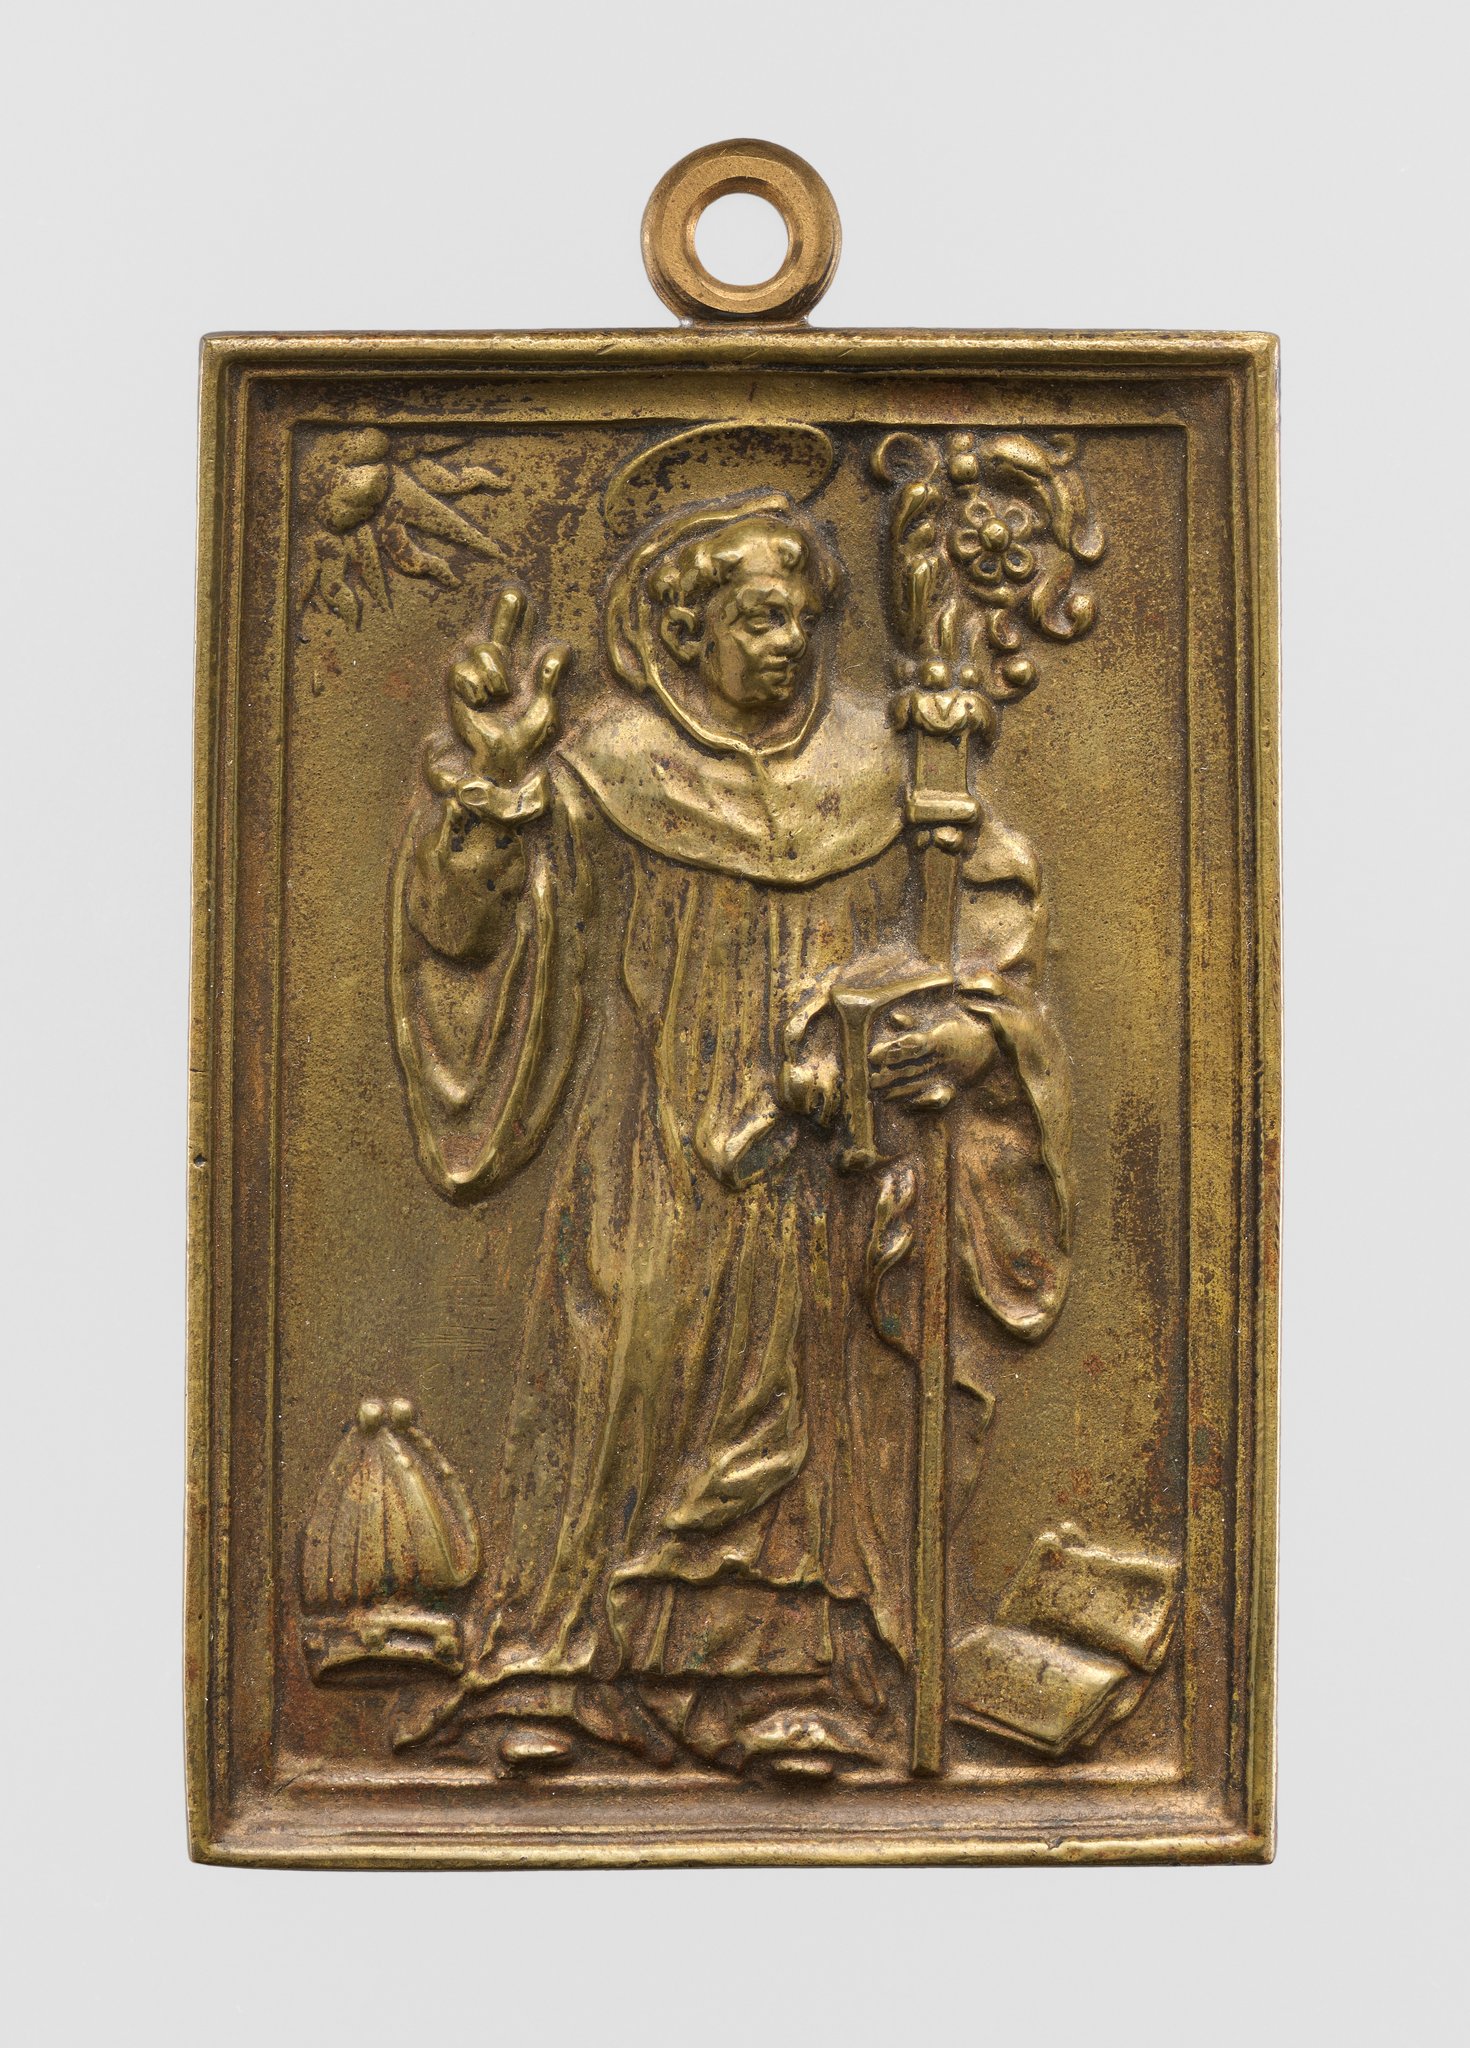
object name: plaquette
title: Saint Benedict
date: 1601-1633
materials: bronze, patina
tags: saints